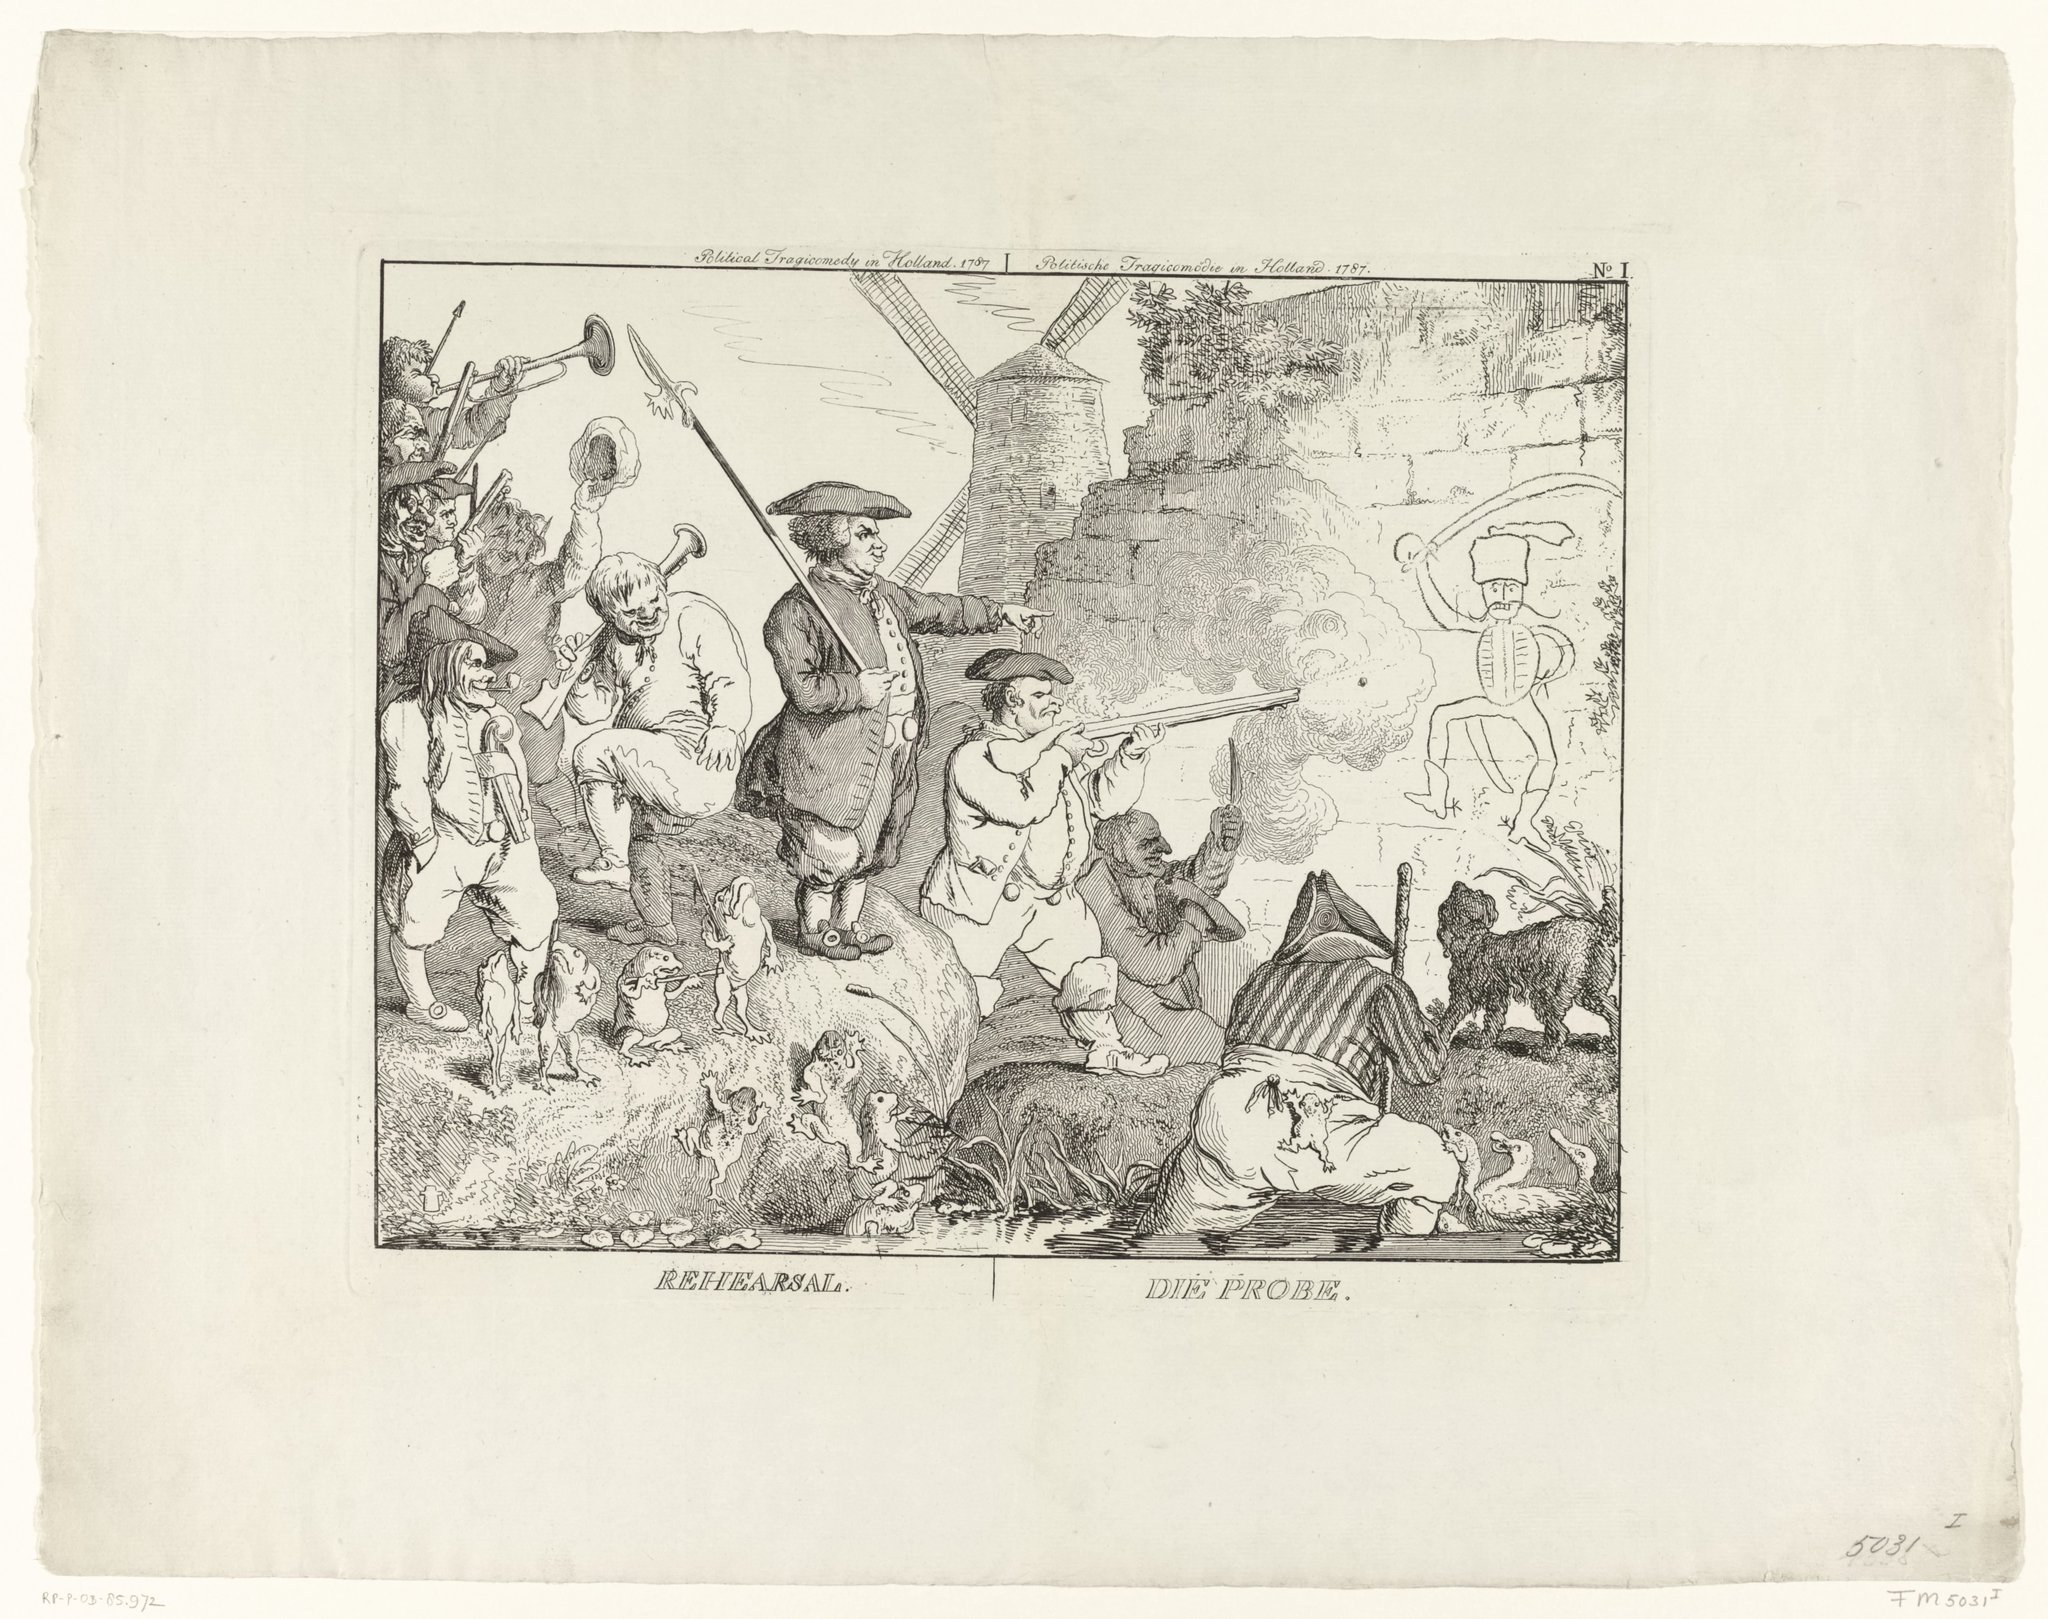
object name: cartoon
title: Rehearsal / Die Probe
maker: johann heinrich ramberg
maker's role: draughtsman, painter, print maker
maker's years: 1763-1840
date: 1787-1788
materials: paper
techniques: etching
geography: england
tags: tailless amphibians: frog, military training (+ citizen soldiery, civil guard, citizen militia), animals acting as human beings, patriots (1780-1795)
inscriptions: collector's mark: Lugt 2228, signature:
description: Hollandse patriotse schutters oefenen met het schieten op een figuur van een boze Pruisische huzaar die op een muur is getekend, tot hilariteit van de betrokkenen en toeschouwers. Kikkers kruipen uit de sloot en doen mee met exerceren. Onderdeel van een groep van vier spotprenten op de patriotten ten tijde van de Pruisische inval in oktober 1787. Herhaling van de originele versie maar nu met Engelse én Duitse opschriften. Zie ook de pendant en het bijbehorende paar spotprenten.